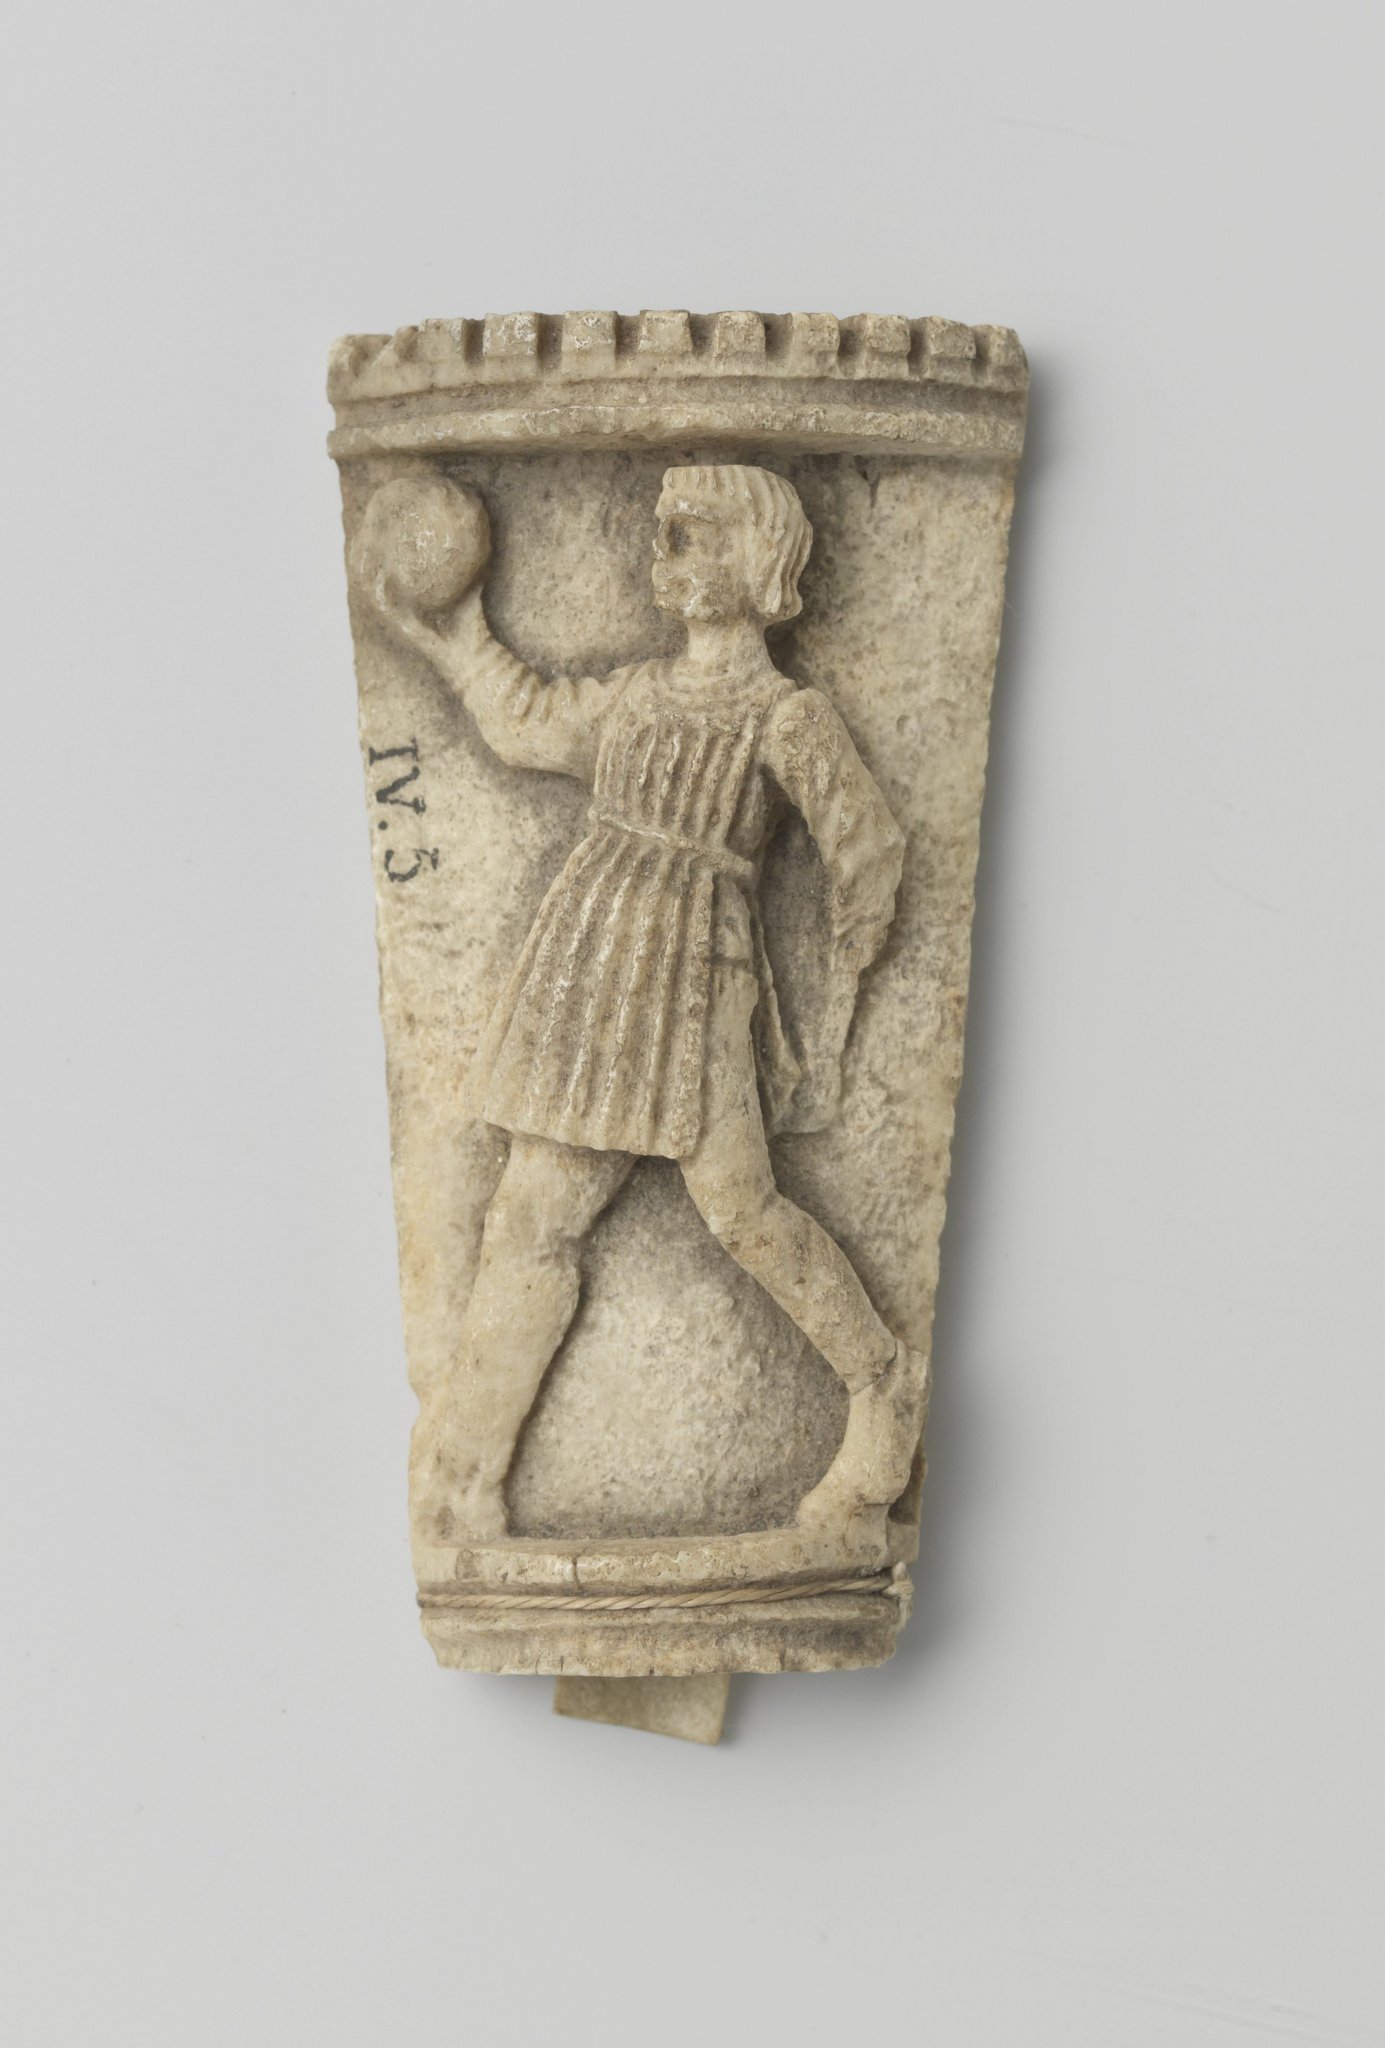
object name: sculpture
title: Voortschrijdende jongeling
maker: baldassare degli embriachi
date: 1400-1425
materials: bone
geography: venice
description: Tapsvormig, licht gebogen reliëf, waarop een voortschrijdende jongeling, die in de opgeheven rechterhand een bol ophoudt.